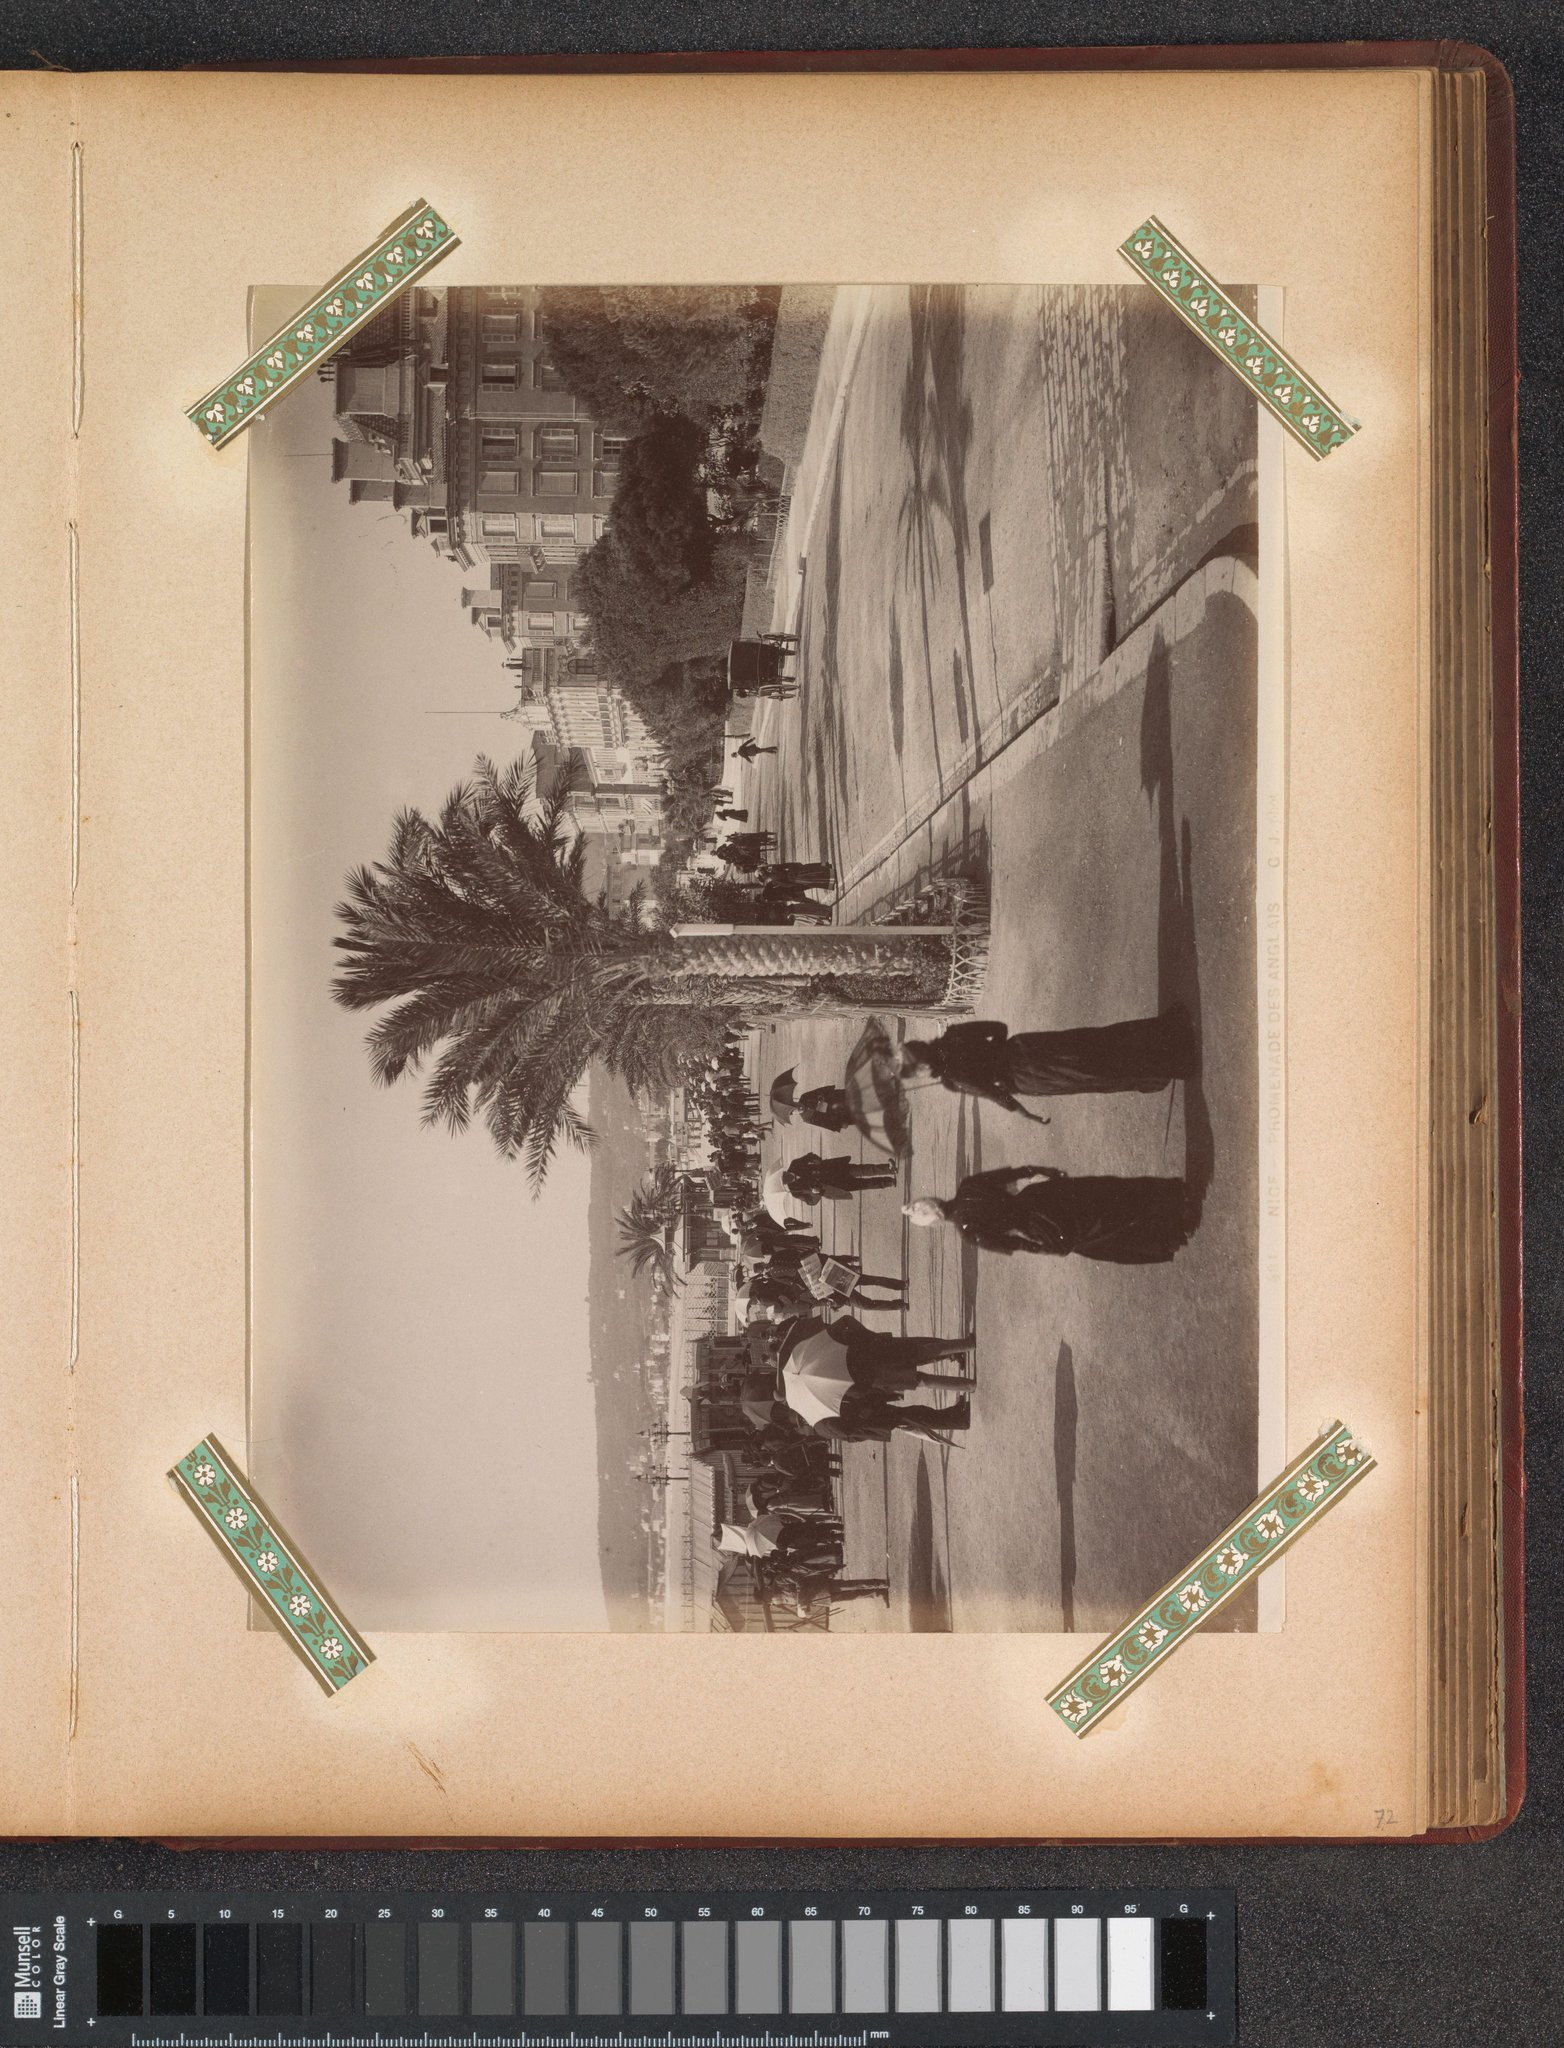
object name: album leaf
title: Nice - Promenade des Anglais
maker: jean gilletta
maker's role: fotograaf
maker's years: 1856-1933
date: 1870-1900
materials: paper, photographic support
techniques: albumen print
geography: nice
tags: strolling, avenue, boulevard, promenade, esplanade (+ city(-scape) with figures, staffage), trees: palm-tree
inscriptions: negative number: ‘481’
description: Onderdeel van Reisalbum met foto's van bezienswaardigheden in Italië en Zuid-Frankrijk.